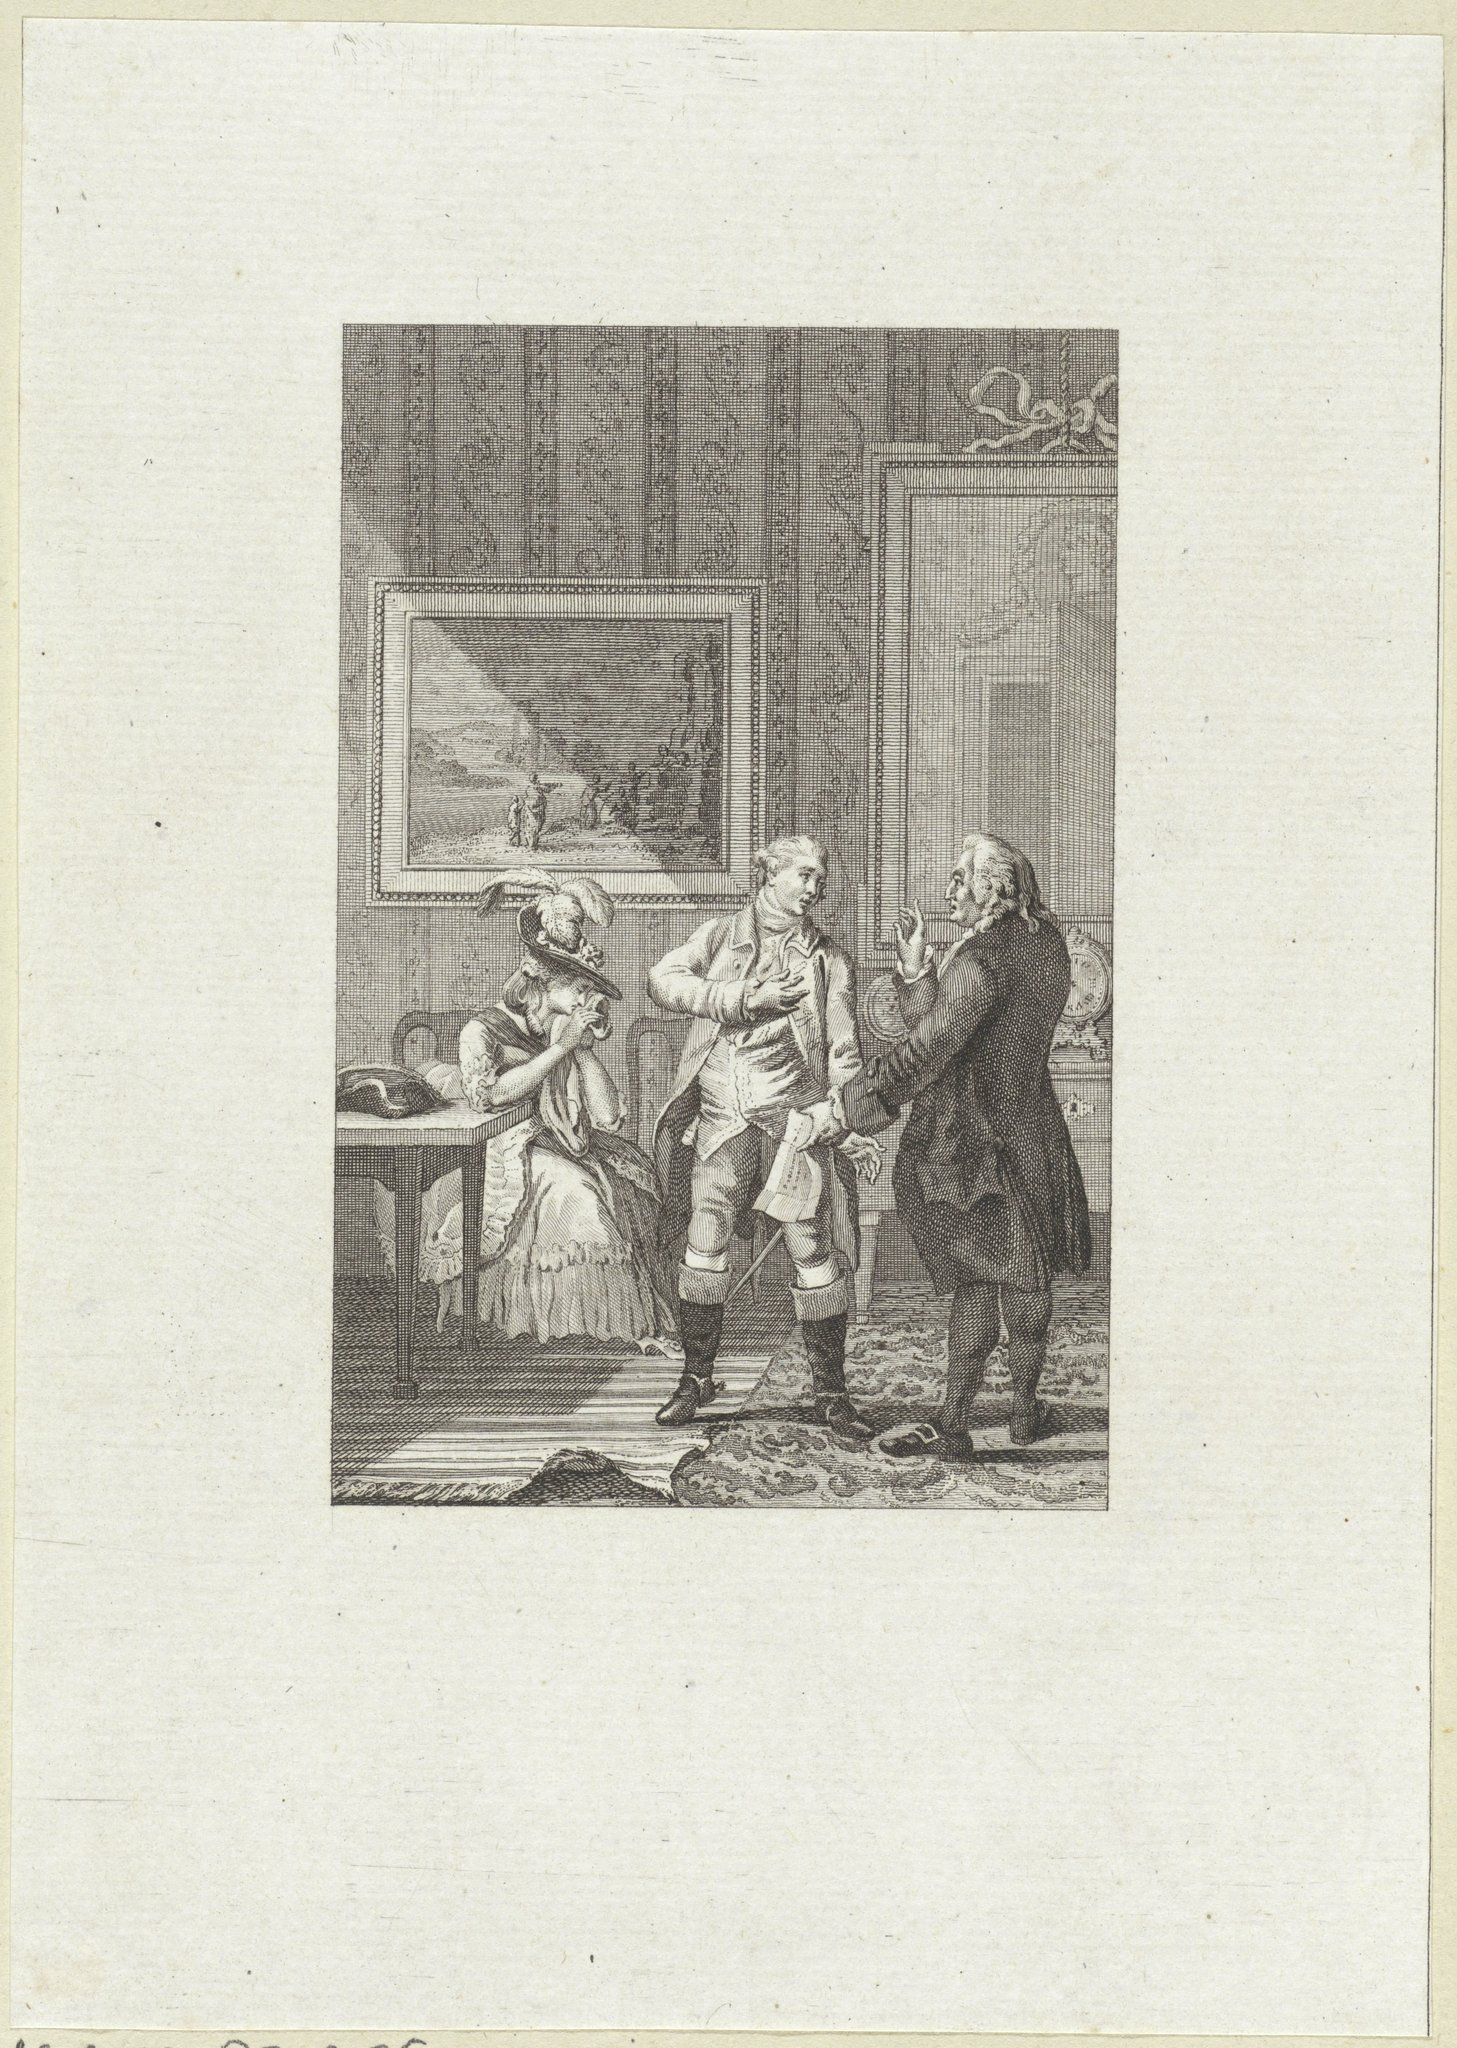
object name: print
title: Twee mannen voeren een gesprek terwijl een jonge vrouw zit te huilen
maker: reinier vinkeles (i)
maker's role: draughtsman, print maker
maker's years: 1741-1816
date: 1784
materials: paper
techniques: engraving, etching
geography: amsterdam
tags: weeping, picture, painting, letter, envelope, conversation, dialogue; conversation piece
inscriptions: collector's mark: Lugt 240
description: Proefdruk van illustratie in: Jester, Ernst Friedrich. Het tweegevegt. Amsterdam: Pieter Meĳer, 1784.